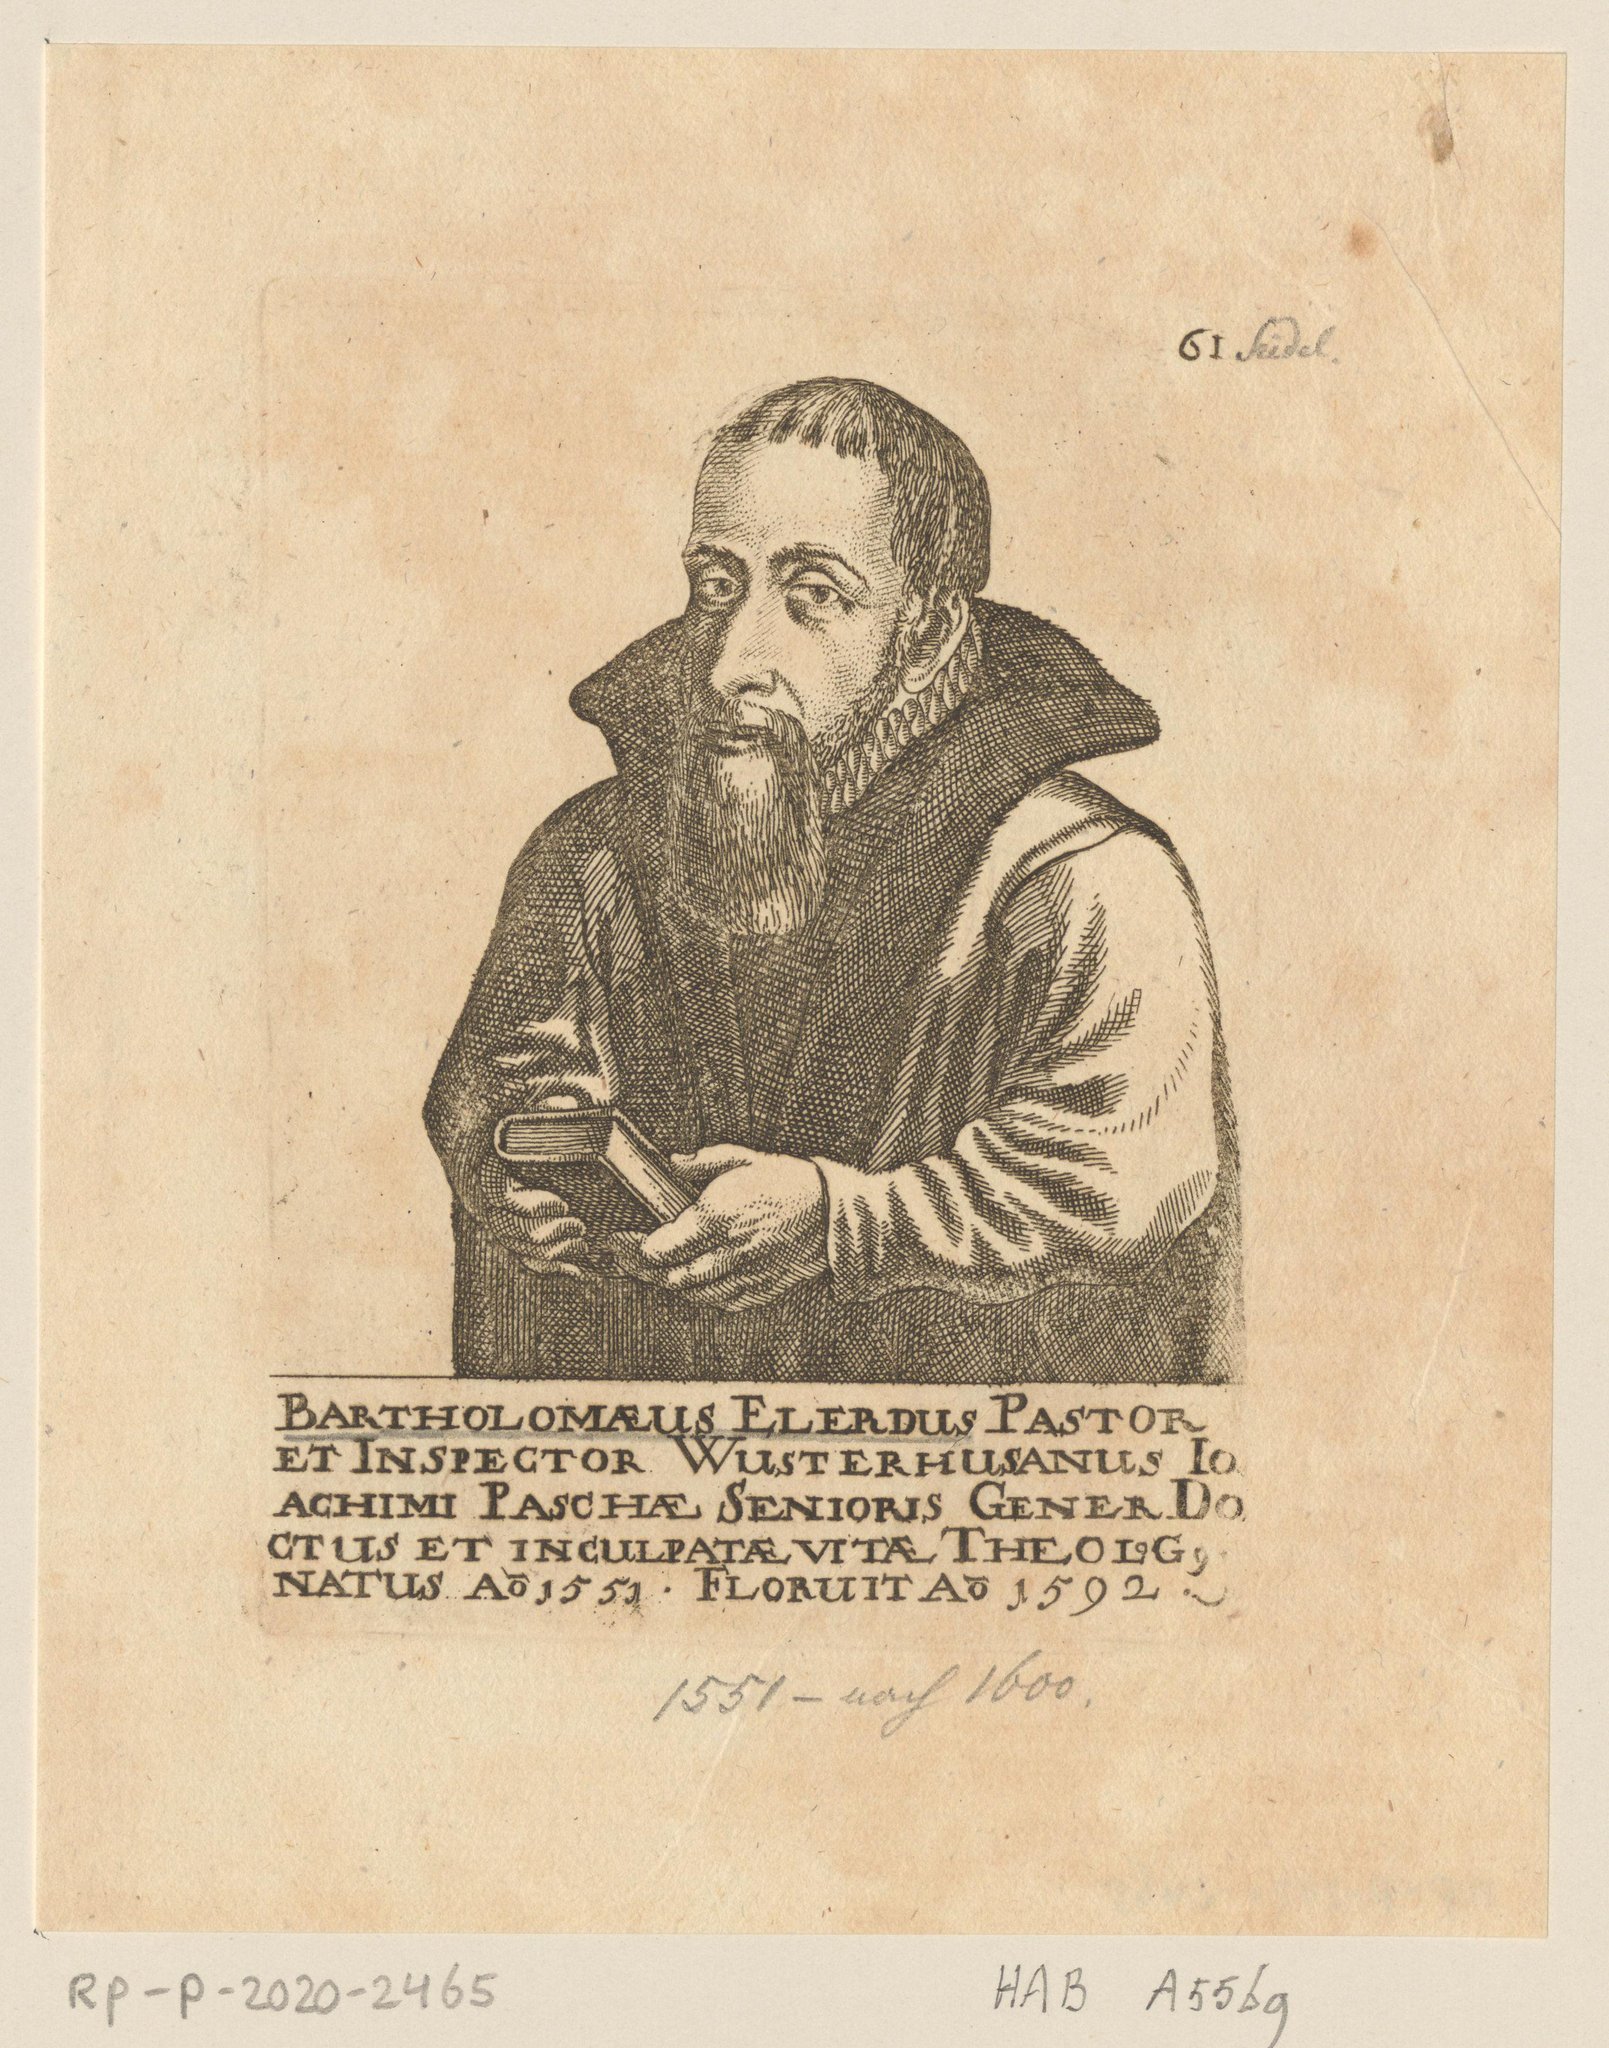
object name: print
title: Portret van Bartholomäus Elerd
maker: Anonymous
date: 1751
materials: paper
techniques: etching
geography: germany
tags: theologian, historical persons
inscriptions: inscription: ‘Seidel’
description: Prent waarschijnlijk uit: Küster, Georg Gottfried en Martin Friedrich Seidel. Martin Friedrich Seidels Bilder-Sammlung (...). Berlijn: Verlag des Buchladens bey der Real-Schule, 1751.